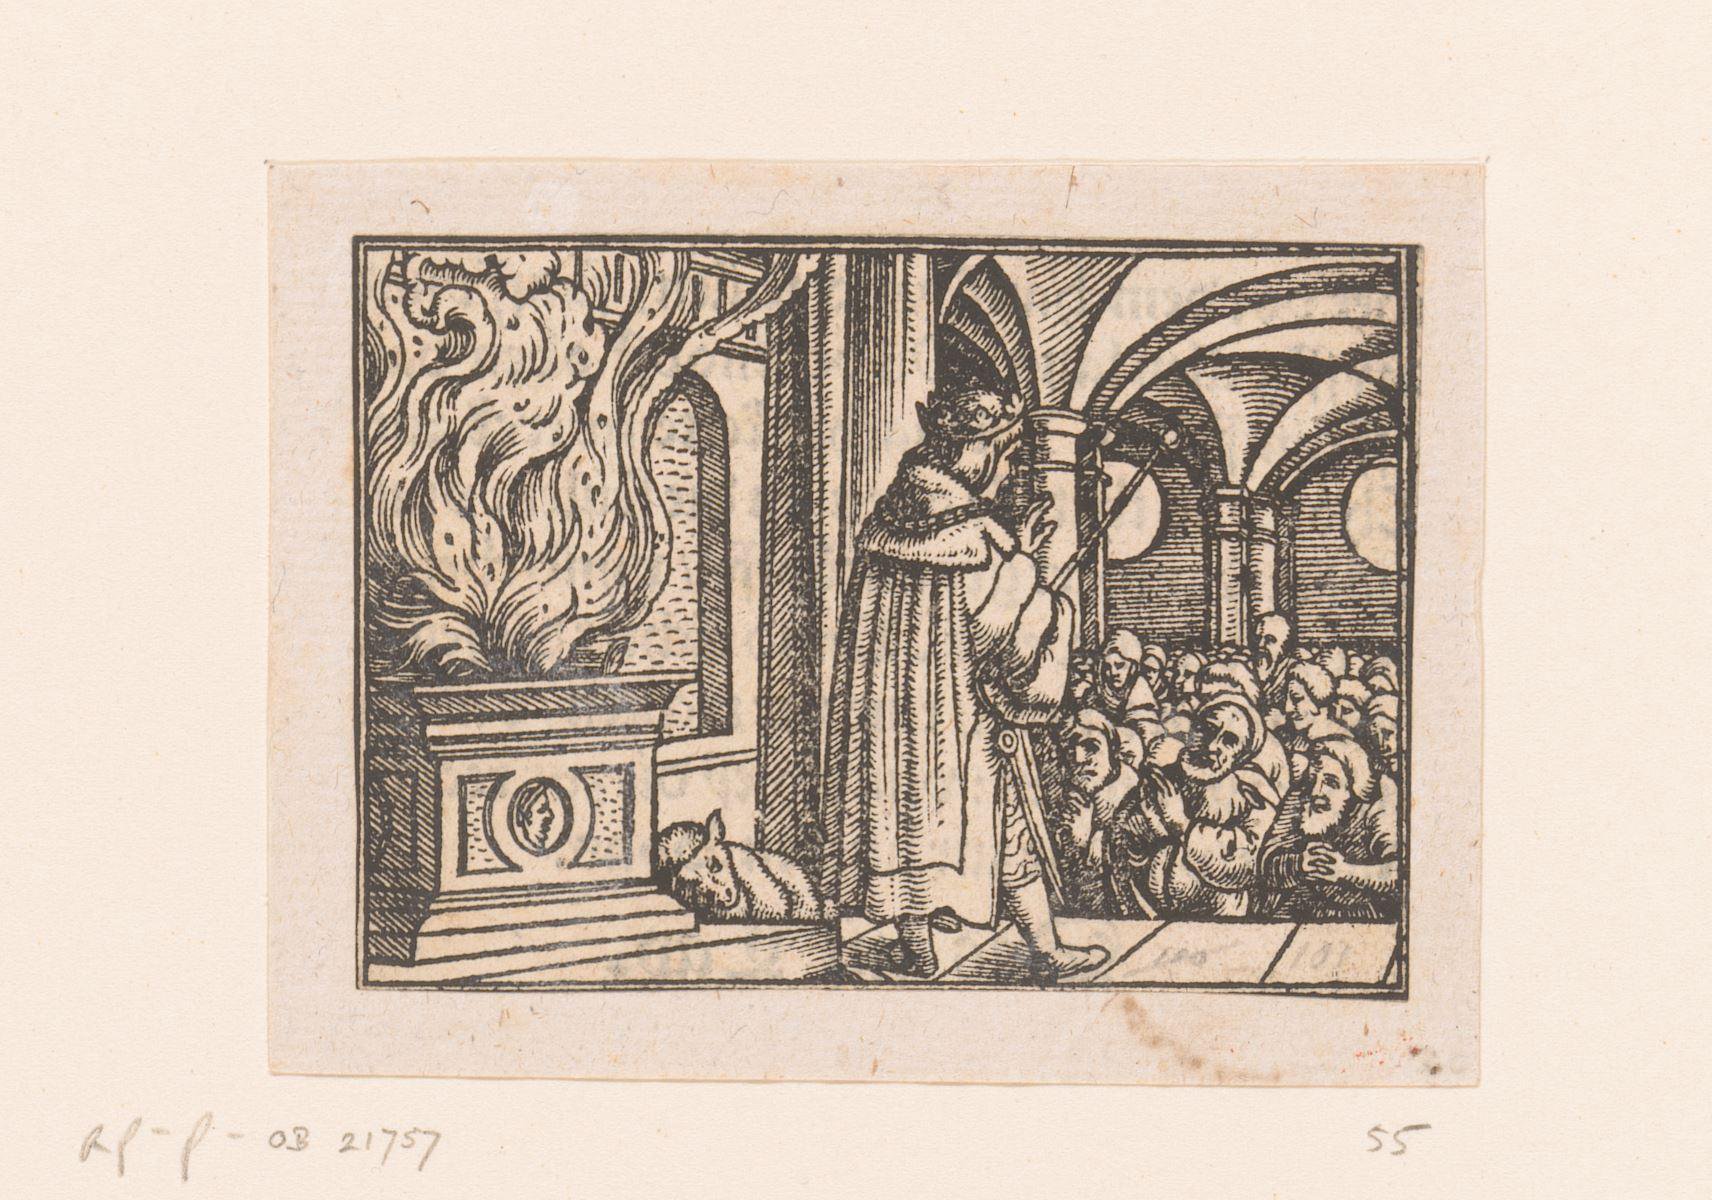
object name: print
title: Salomon zegent het volk in de tempel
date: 1552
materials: paper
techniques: woodcut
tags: solomon blesses the people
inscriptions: collector's mark: Lugt 240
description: Gespiegelde kopie van een houtsnede van Hans Holbein de jongere uit 1526. Origineel voor het eerst als boekillustratie gebruikt in: Biblia Utriusque Testamenti iuxta Vulgatam Translationem, Lyon, M. en G. Trechsel (voor Hugo à Porta) 1538. Deze kopie gemaakt voor: Biblia sacra iuxta vulgatam. Parijs: Jean Benoît, 1552.